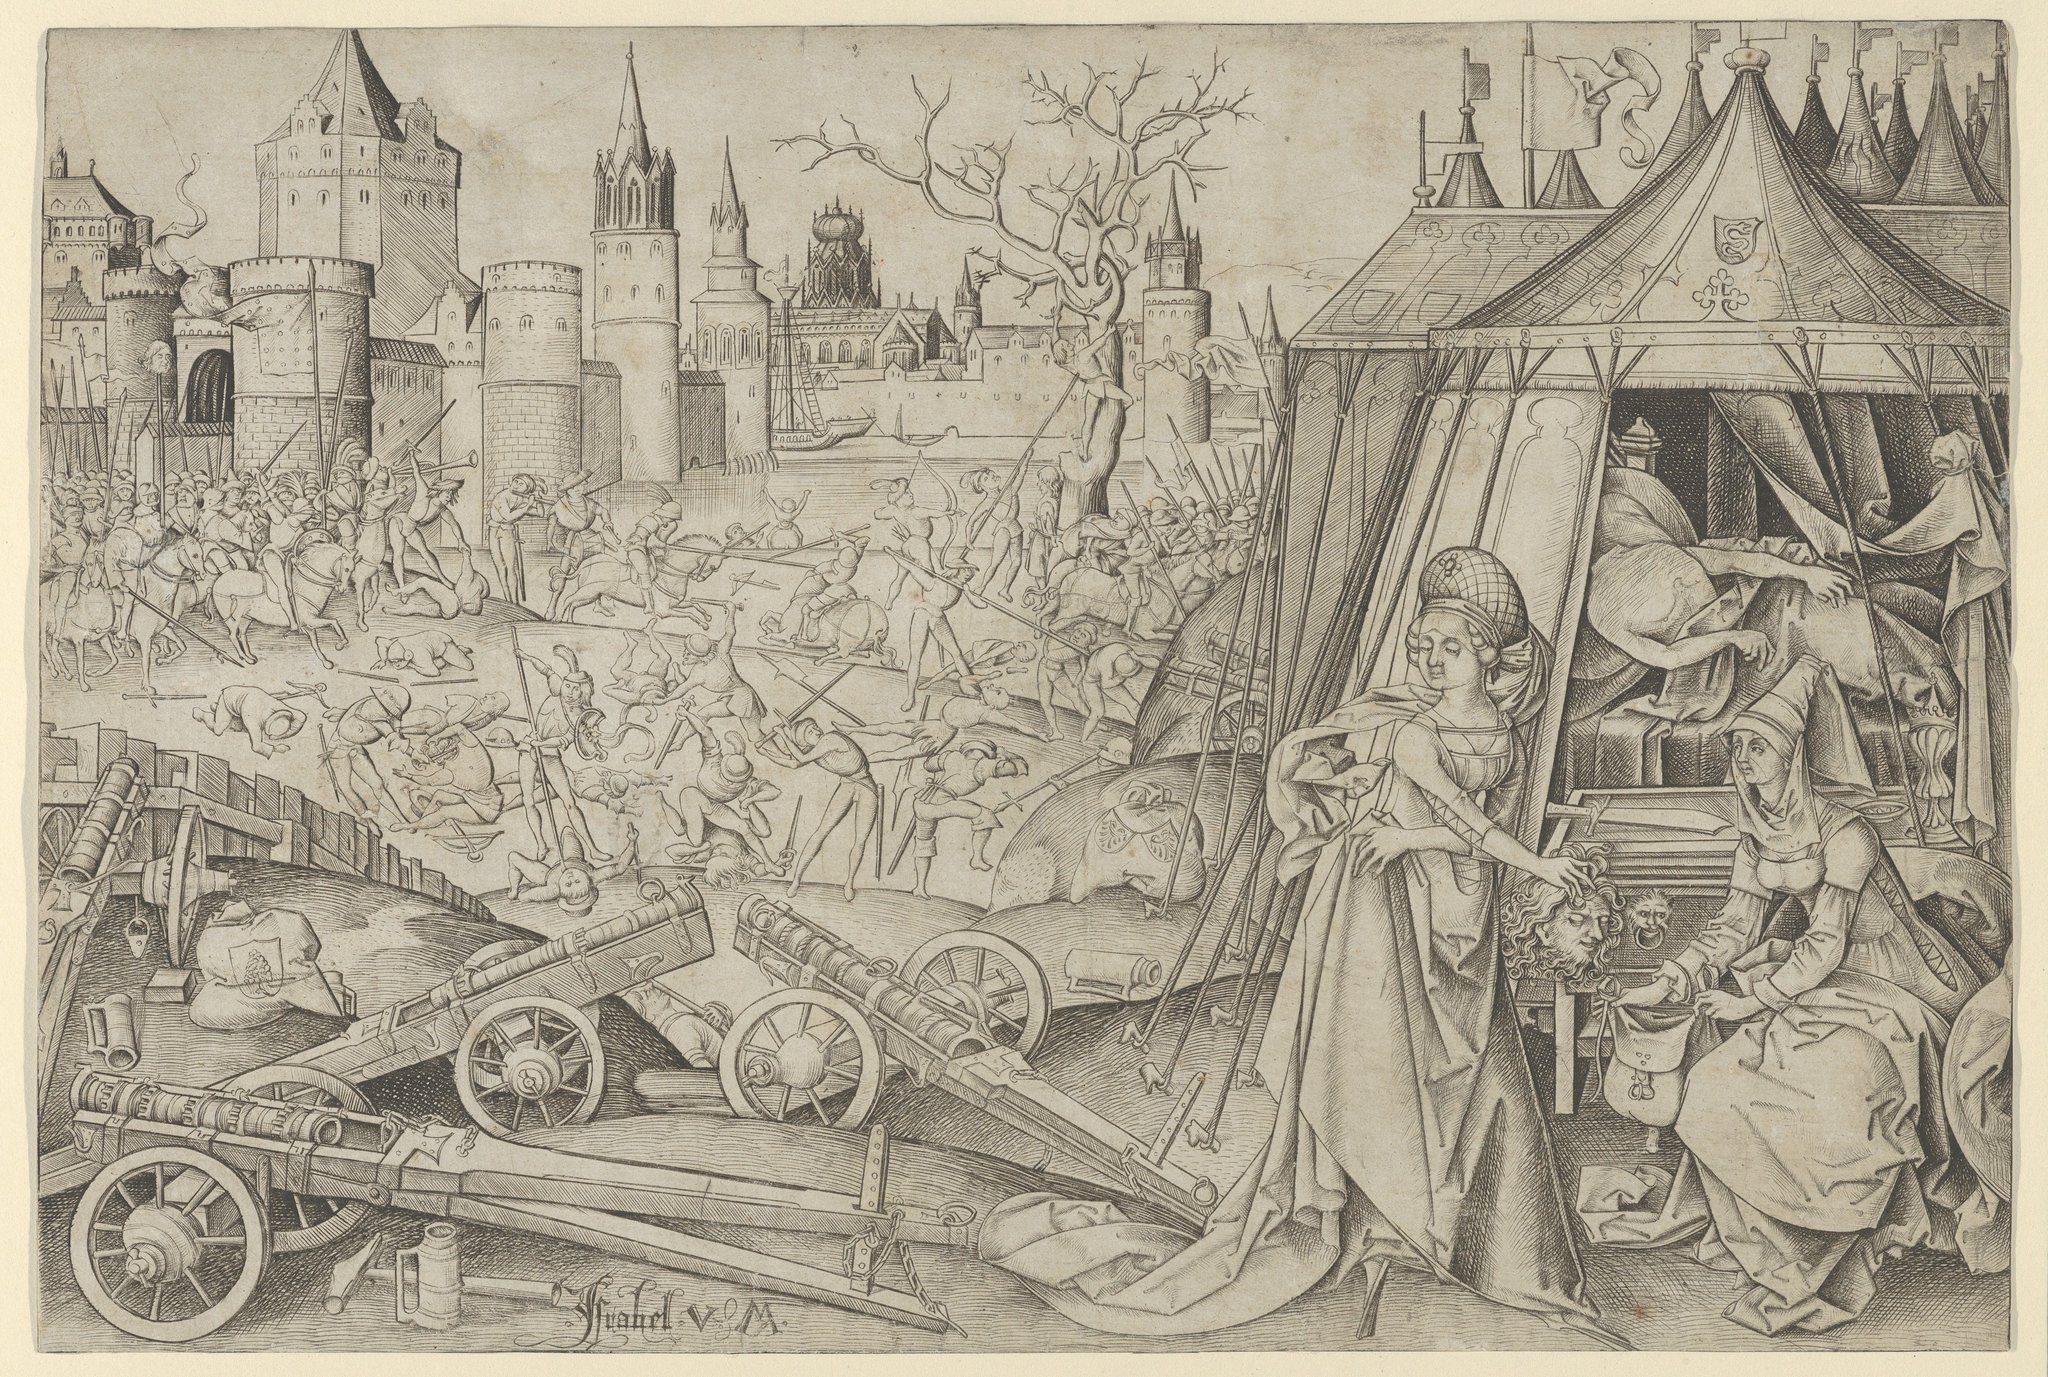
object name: print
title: Judith with the Head of Holophernes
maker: israhel van meckenem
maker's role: artist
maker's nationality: german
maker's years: 1435-1503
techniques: engraving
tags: weapons,cannons,heads,horses,judith